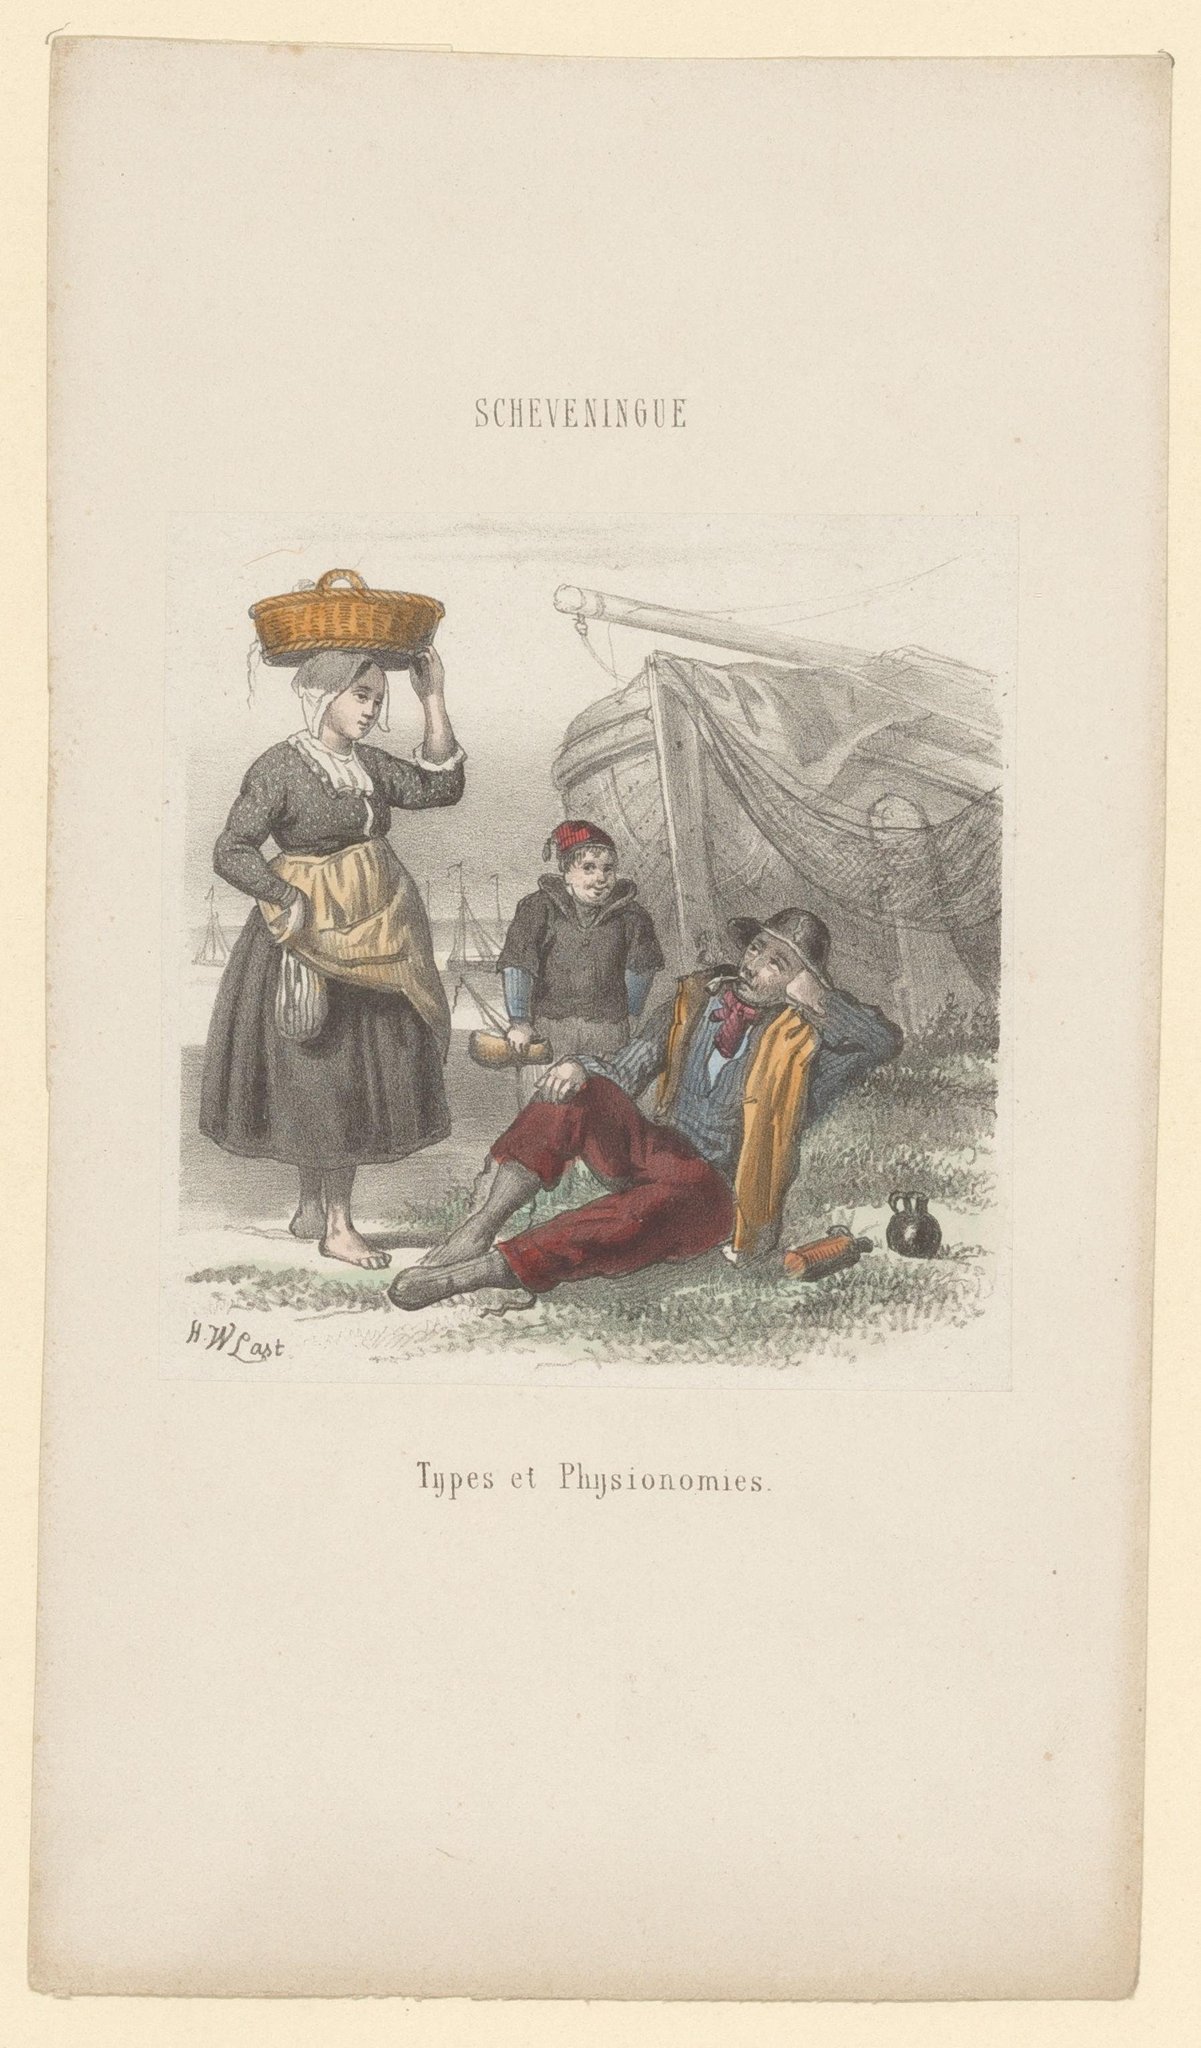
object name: print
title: Scheveningue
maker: hendrik wilhelmus last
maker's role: print maker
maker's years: 1817-1873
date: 1856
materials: watercolor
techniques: hand coloring, lithograph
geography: netherlands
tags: sea and coastal fishery (+ men (labourers)), family group, especially parents with their child(ren), sea and coastal fishery (+ women (labourers)), clothes, costume (+ women's clothes), clothes, costume (+ men's clothes), folk costume, regional costume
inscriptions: collector's mark: Lugt 1641, collector's mark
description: Gebruikt als illustratie: Souvenir de Schéveningue. Dessiné d'après nature par H. W. Last. [Herinnering aan Scheveningen]. Uitgegeven door M. J. Visser, La Haye, 1856.